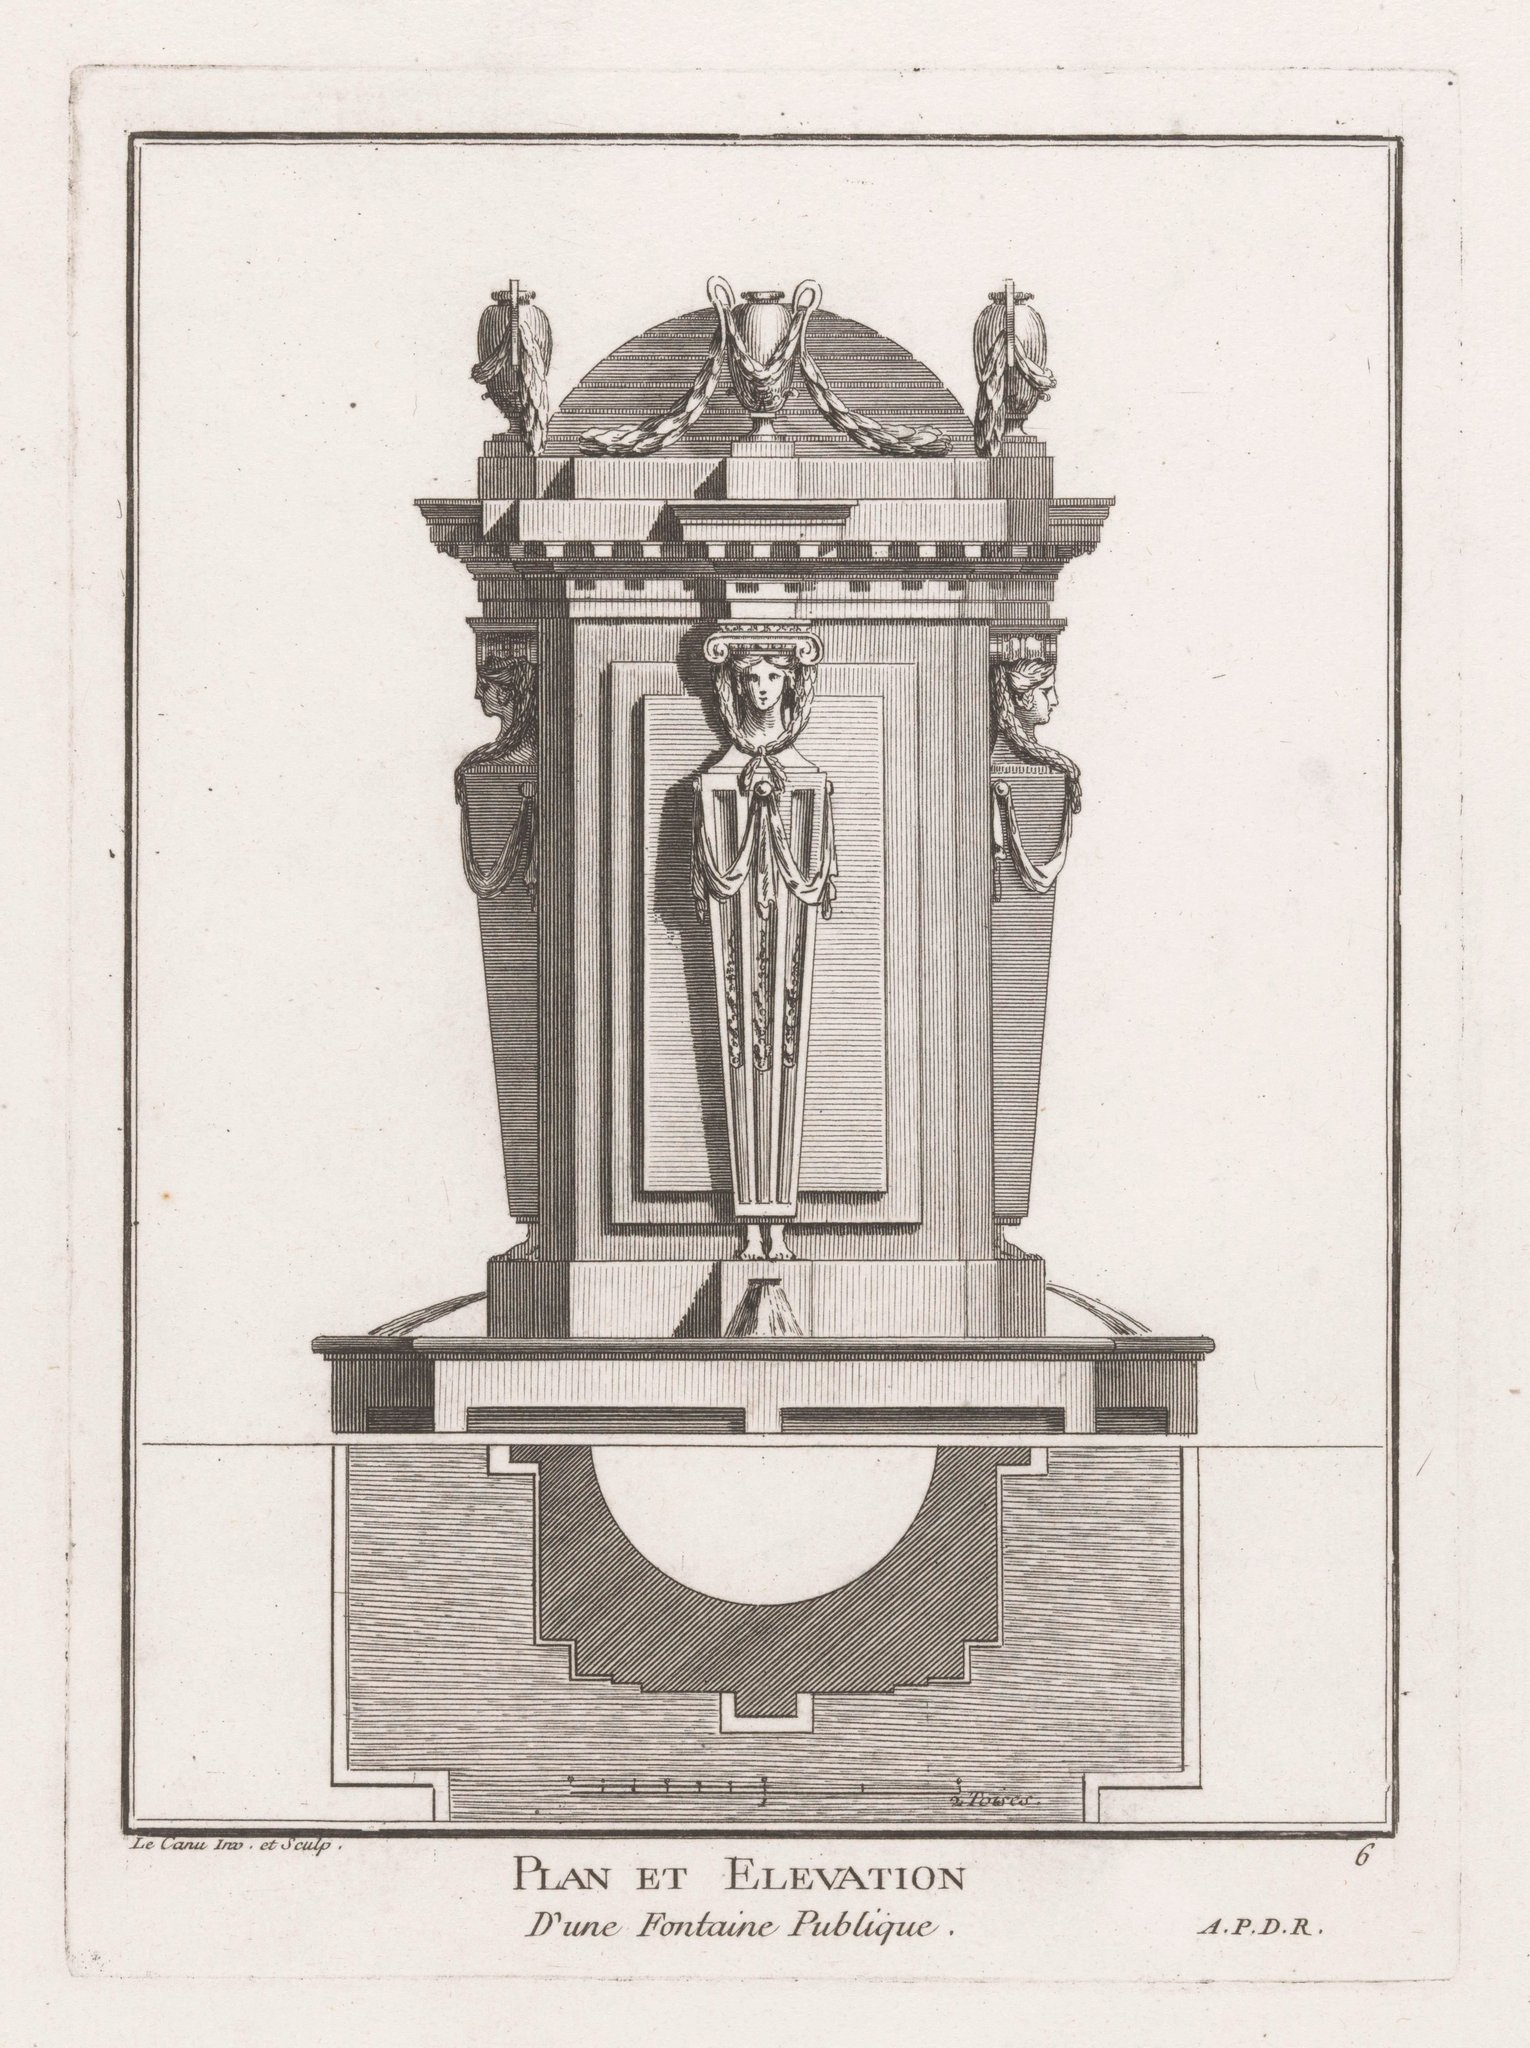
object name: ornament print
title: Fontein met kariatiden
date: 1778-1782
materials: paper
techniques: etching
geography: paris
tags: caryatids ~ architecture, ornamental fountain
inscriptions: collector's mark: Lugt 2760, collector's mark: Lugt 2228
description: Vooraanzicht en plattegrond van een geornamenteerde fontein met kariatiden aan iedere zijde, daarboven staan vazen met guirlandes.